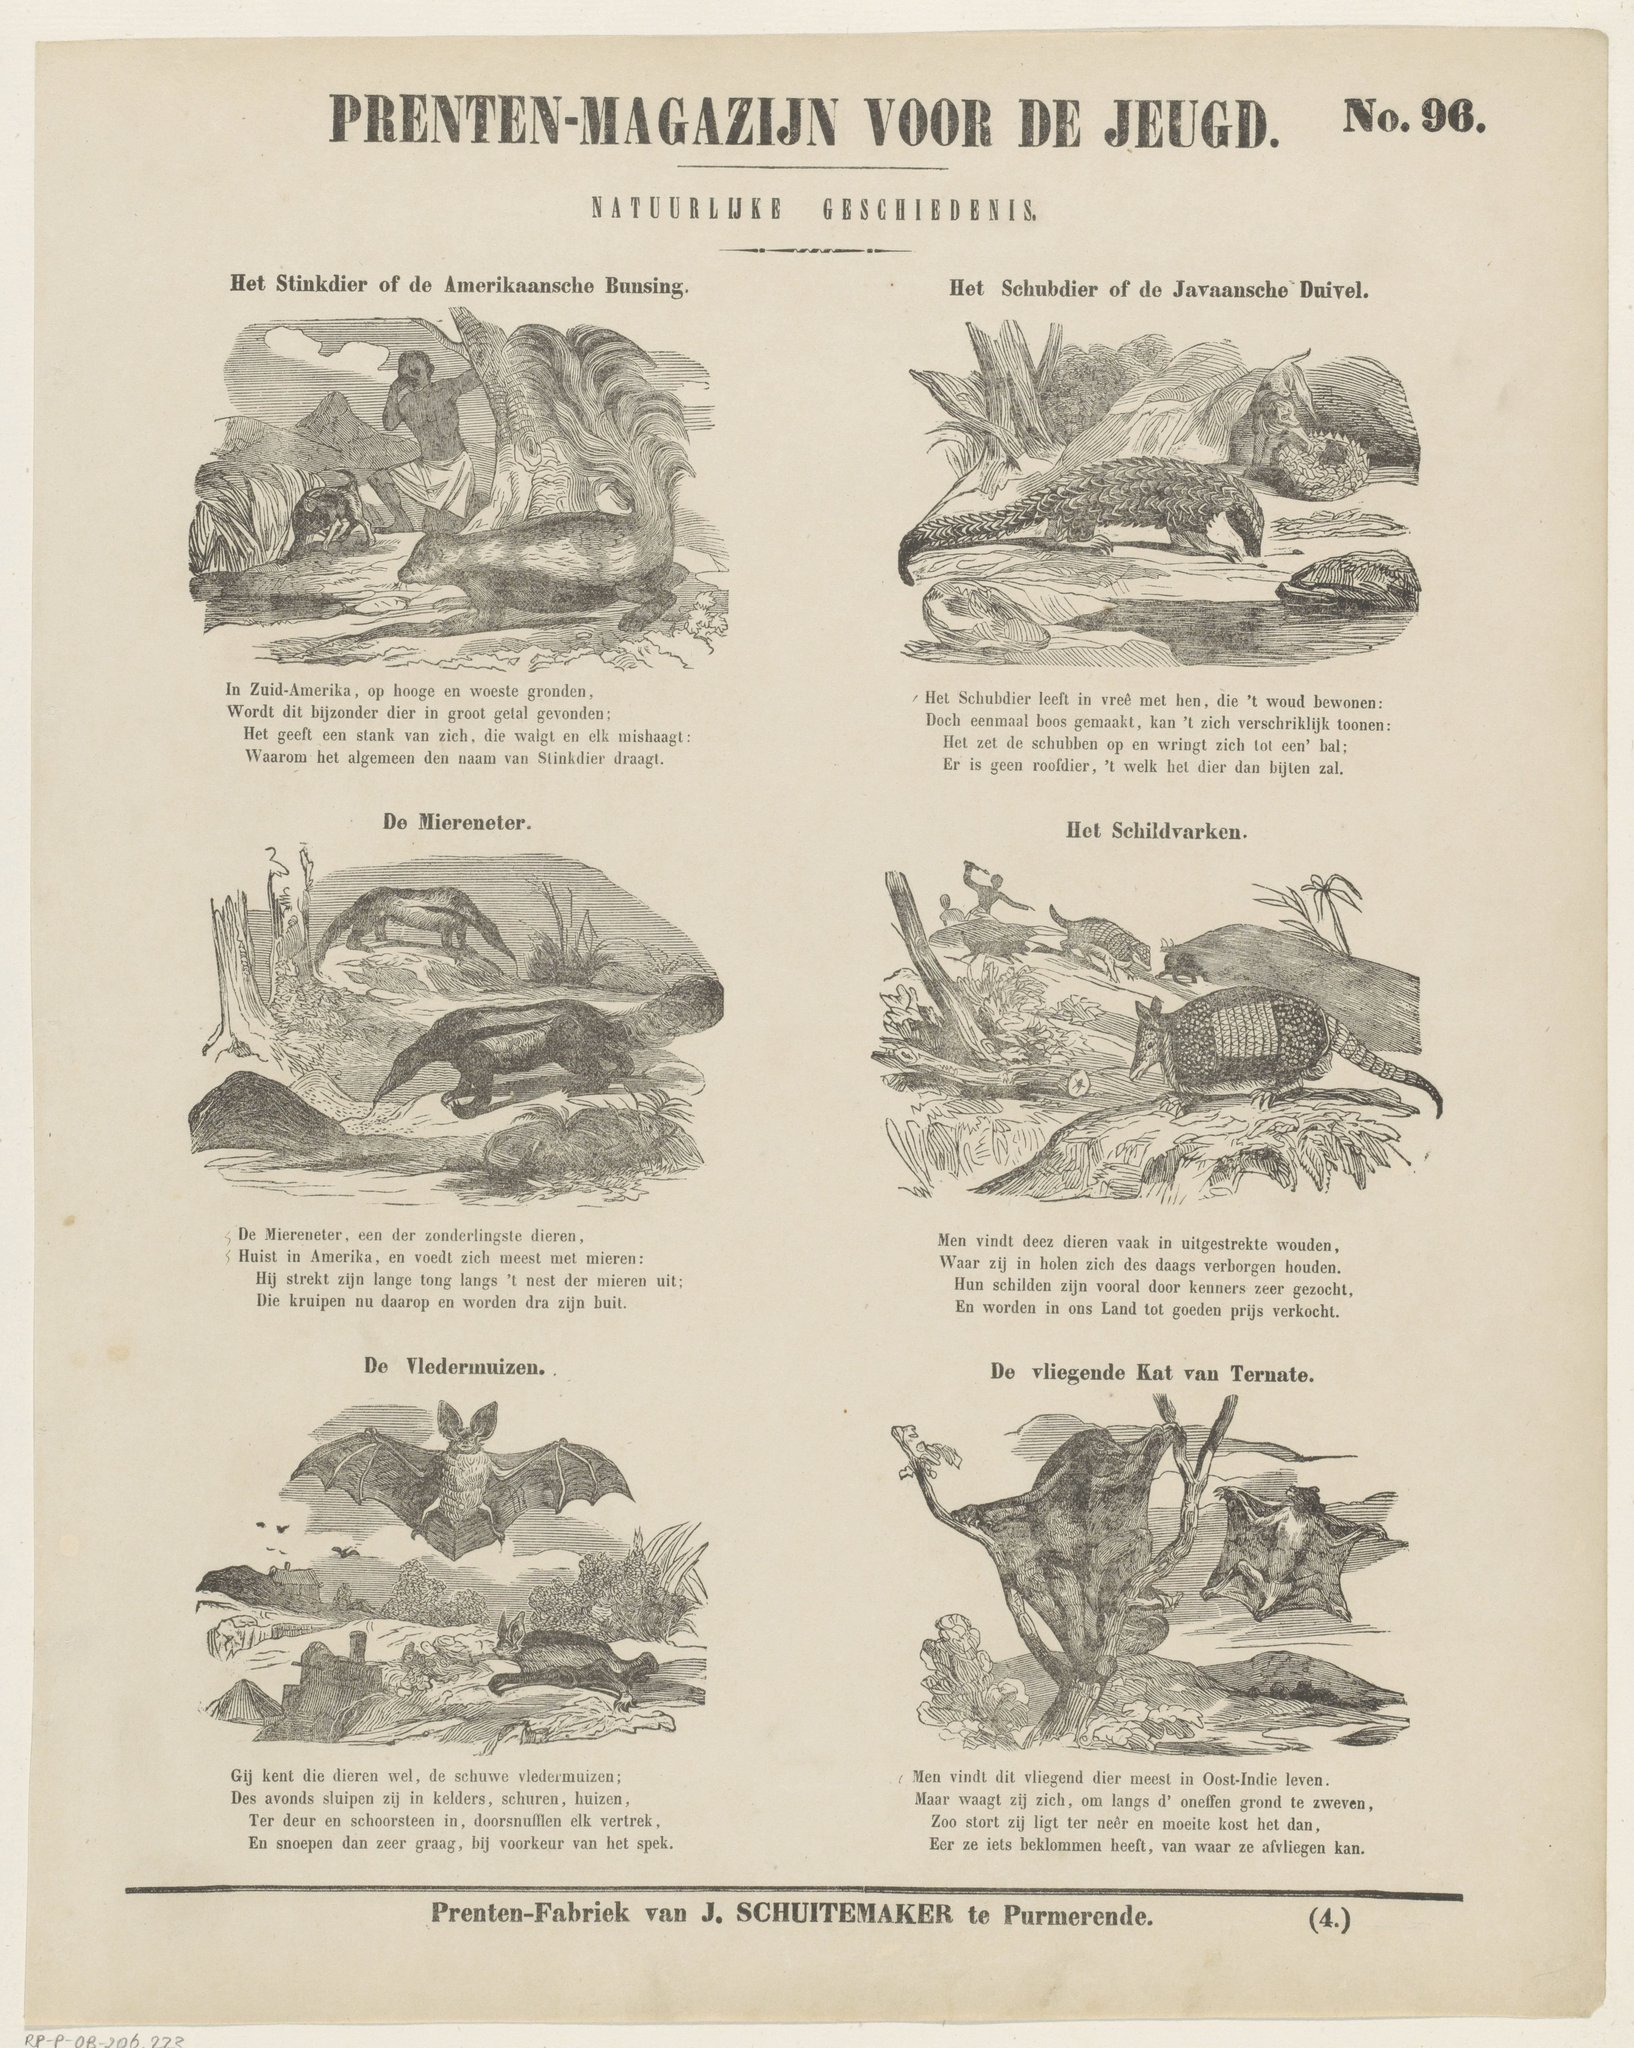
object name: print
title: Dieren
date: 1850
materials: paper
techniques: letterpress printing, engraving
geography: purmerend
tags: flying mammals: bat, animals, other mammals: armadillo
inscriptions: collector's mark: Lugt 2760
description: Na voltooiing van de acht jaargangen van de reeks 'Prenten-magazijn voor de jeugd' in 1850 heeft Jan Schuitemaker al deze prenten heruitgegeven en omgenummerd als nr. 1 t/m 192. De oorspronkelijke jaargang wordt telkens nog vermeld rechtsonder op de prent. Binnen de jaargangen zijn prenten van hetzelfde thema in clusters van vier achter elkaar gezet.